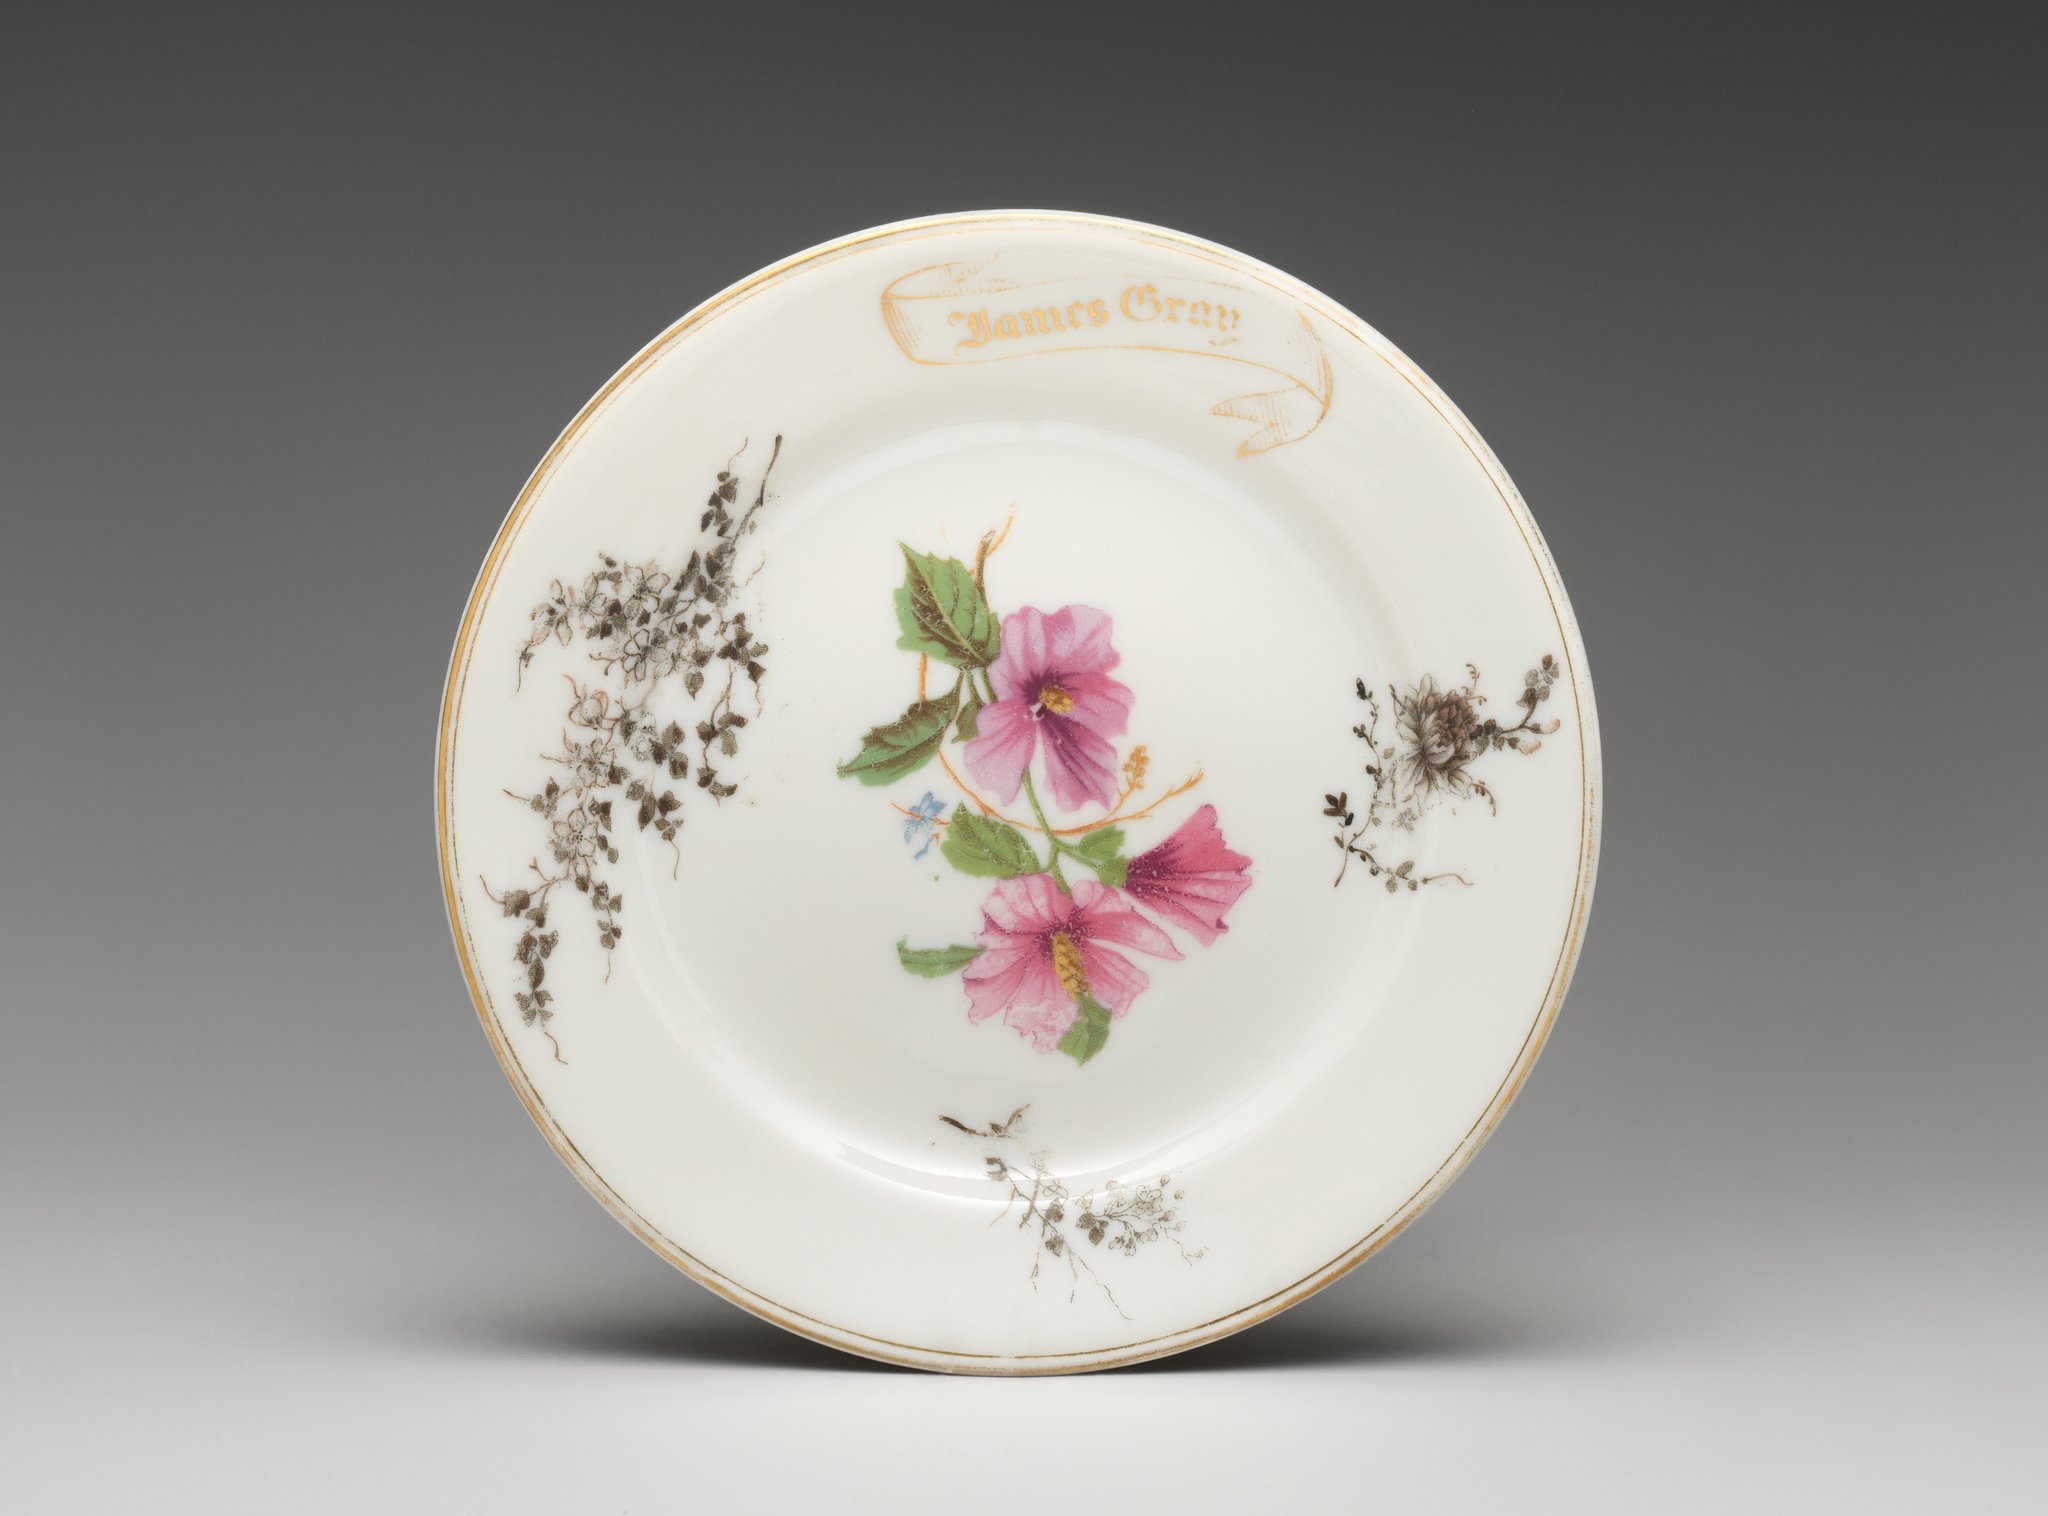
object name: plate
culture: american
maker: union porcelain works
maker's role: maker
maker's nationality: american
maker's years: 1863-1922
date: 1880-1895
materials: porcelain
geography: united states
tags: flowers